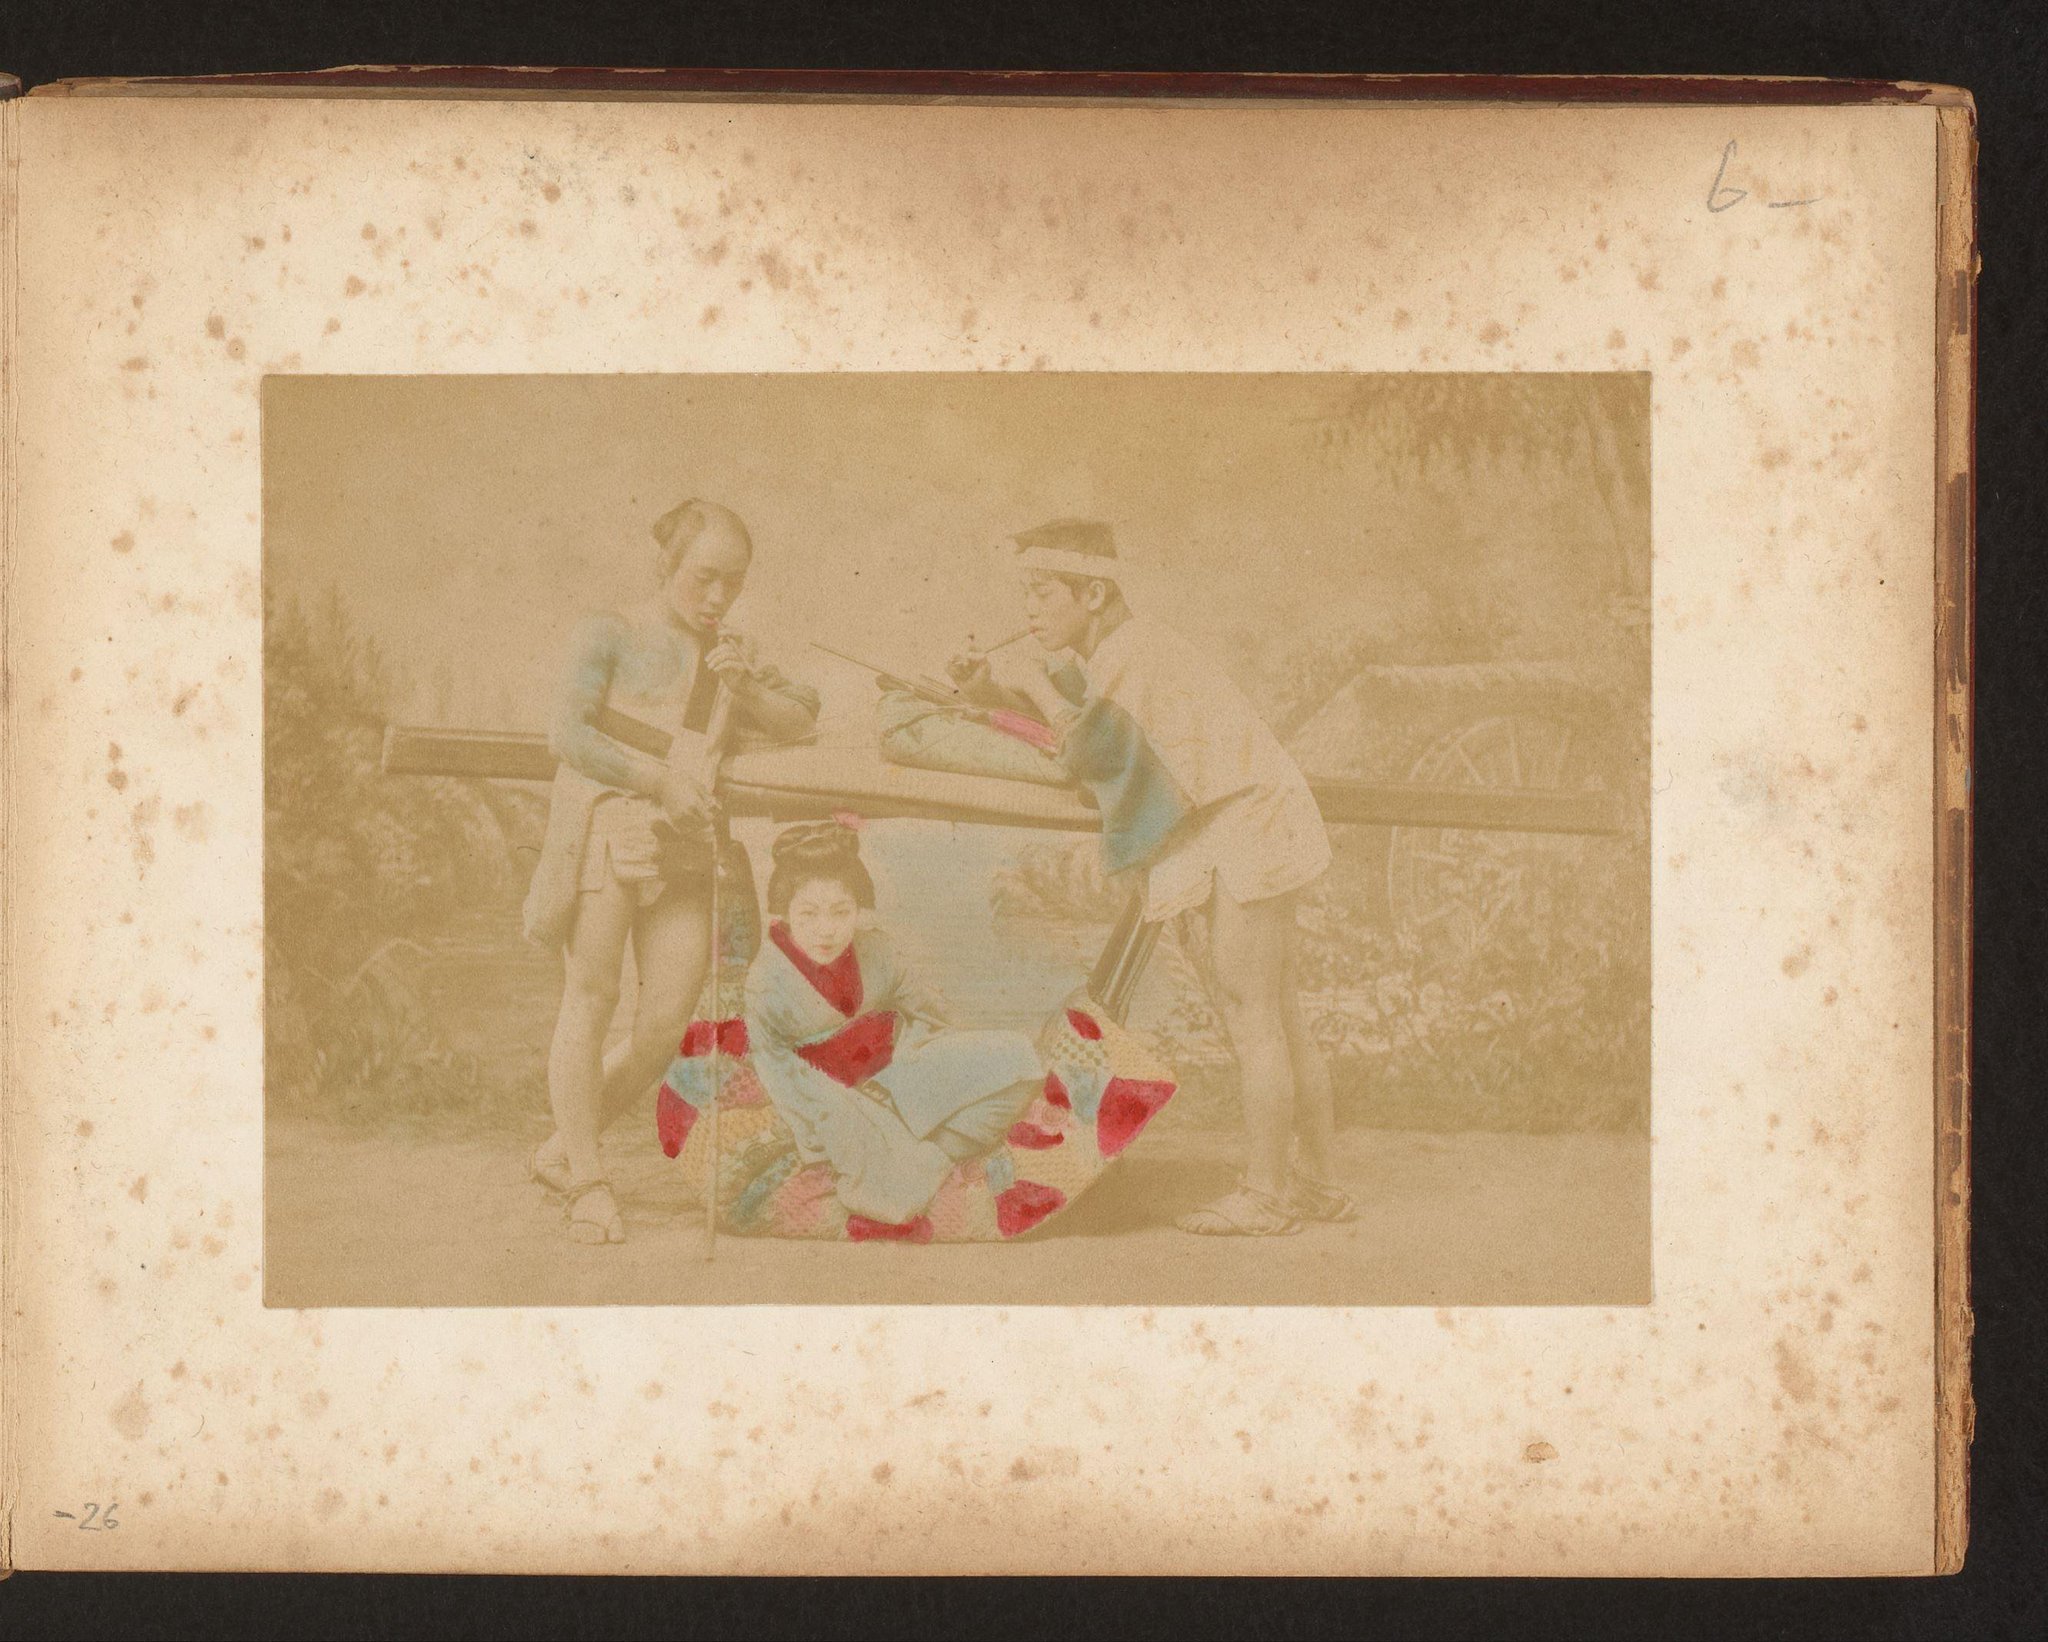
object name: album leaf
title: Draagbaar met een vrouw en twee mannelijke dragers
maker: Anonymous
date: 1851-1900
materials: paper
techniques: albumen print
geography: japan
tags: (carrying a person on a) litter, stretcher, japan